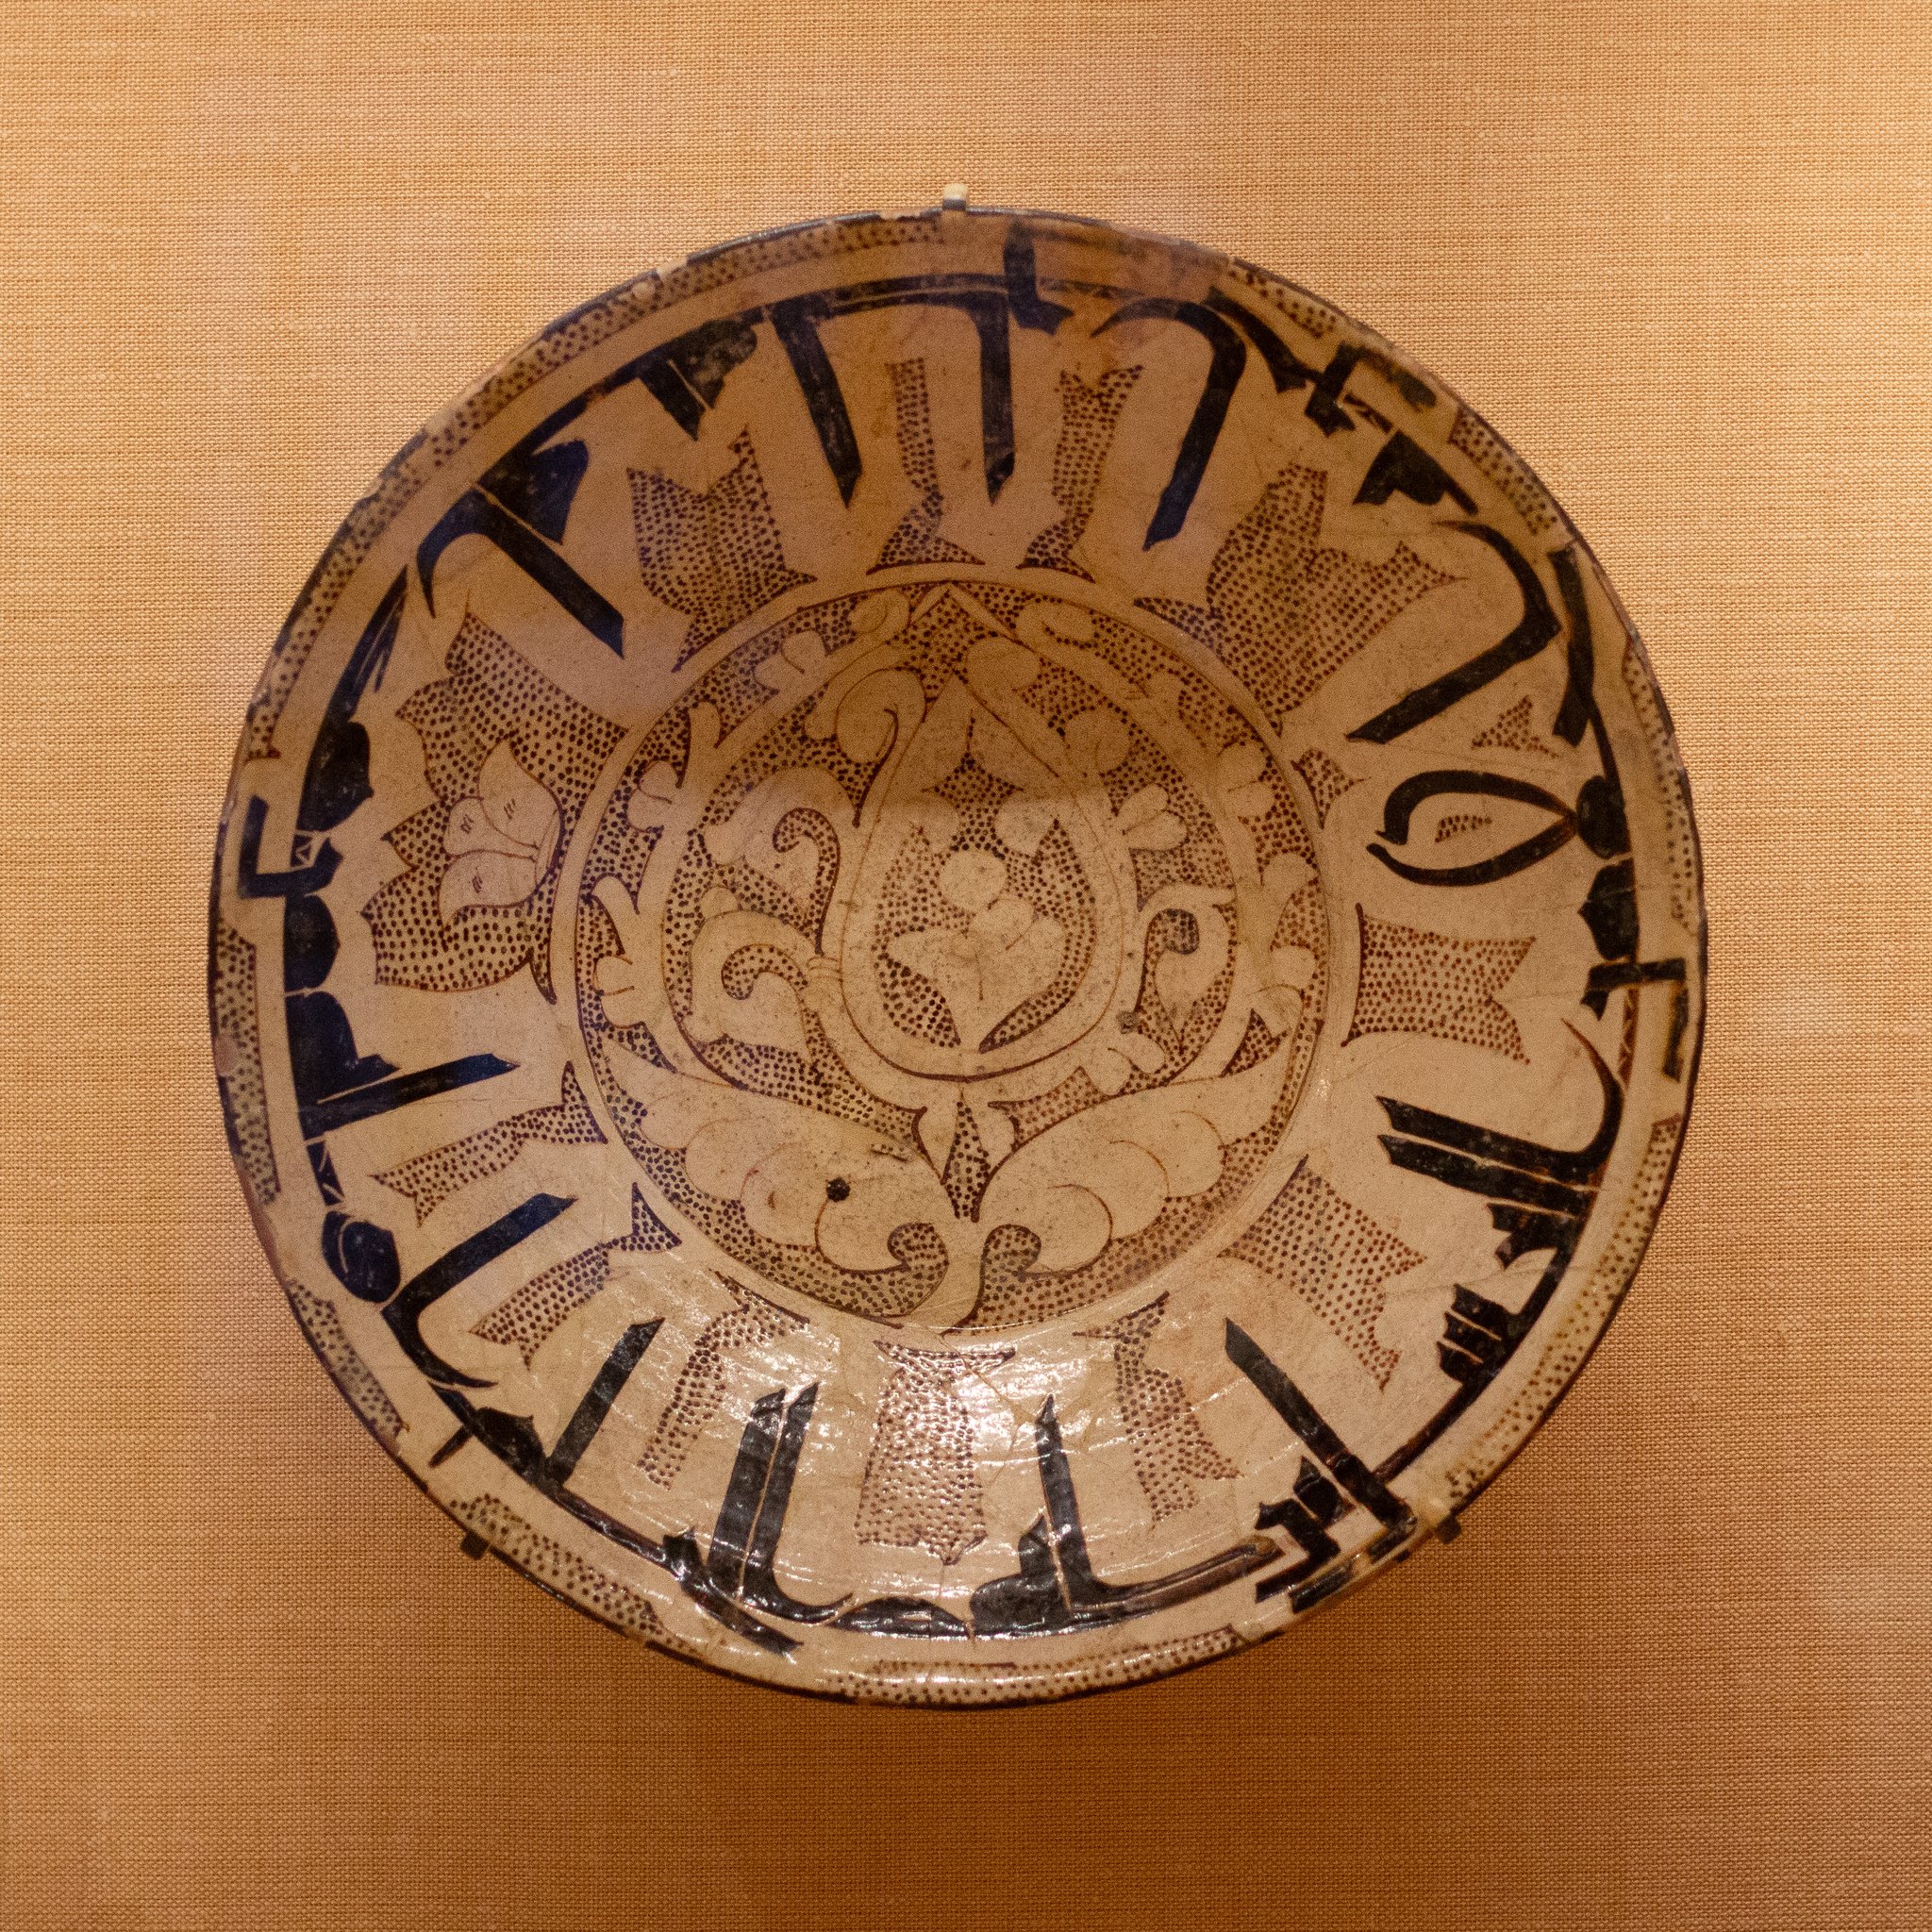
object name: bowl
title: Bowl with Arabic Proverb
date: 967-1100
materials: earthenware, glaze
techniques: polychrome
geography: uzbekistan